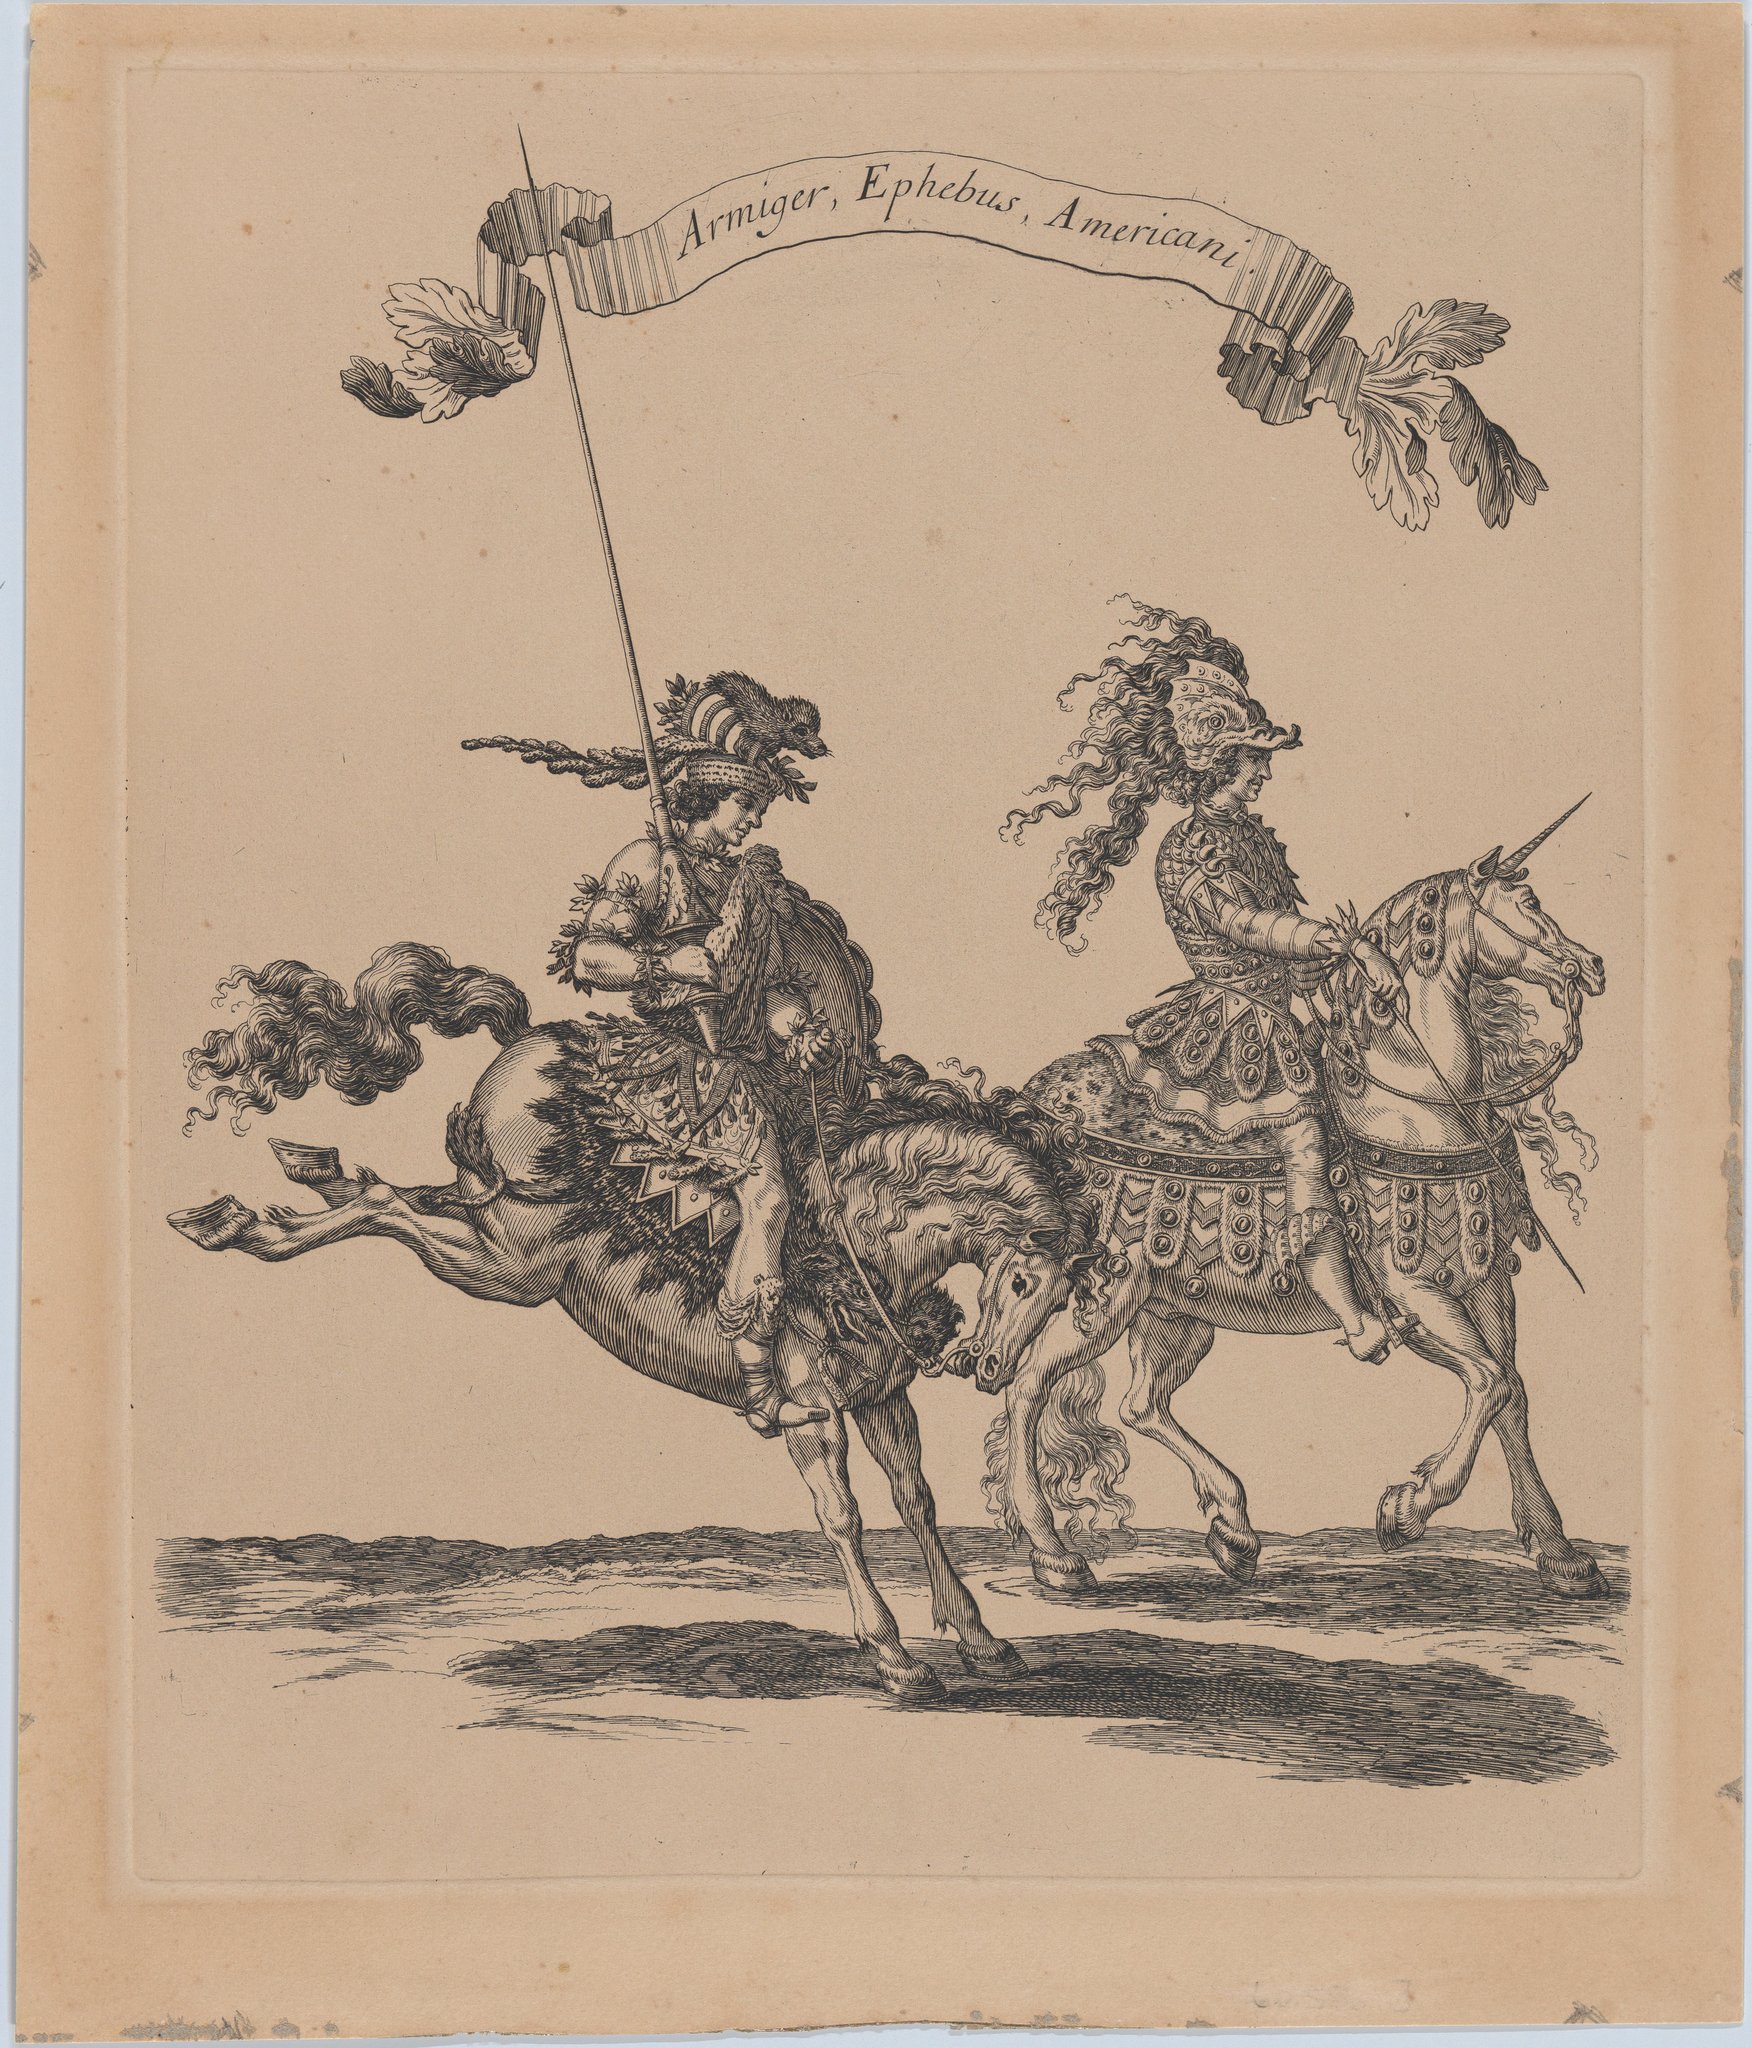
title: Armiger, Ephebus, Americani, from "Courses de Testes et de Bagues Faittes par Roy et par les Princes et Signeurs de sa Cour, en l'annee 1662" (Grand Carrousel)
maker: françois chauveau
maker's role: artist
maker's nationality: french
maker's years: 1613-1676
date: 1662-1670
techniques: etching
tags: princes,horses